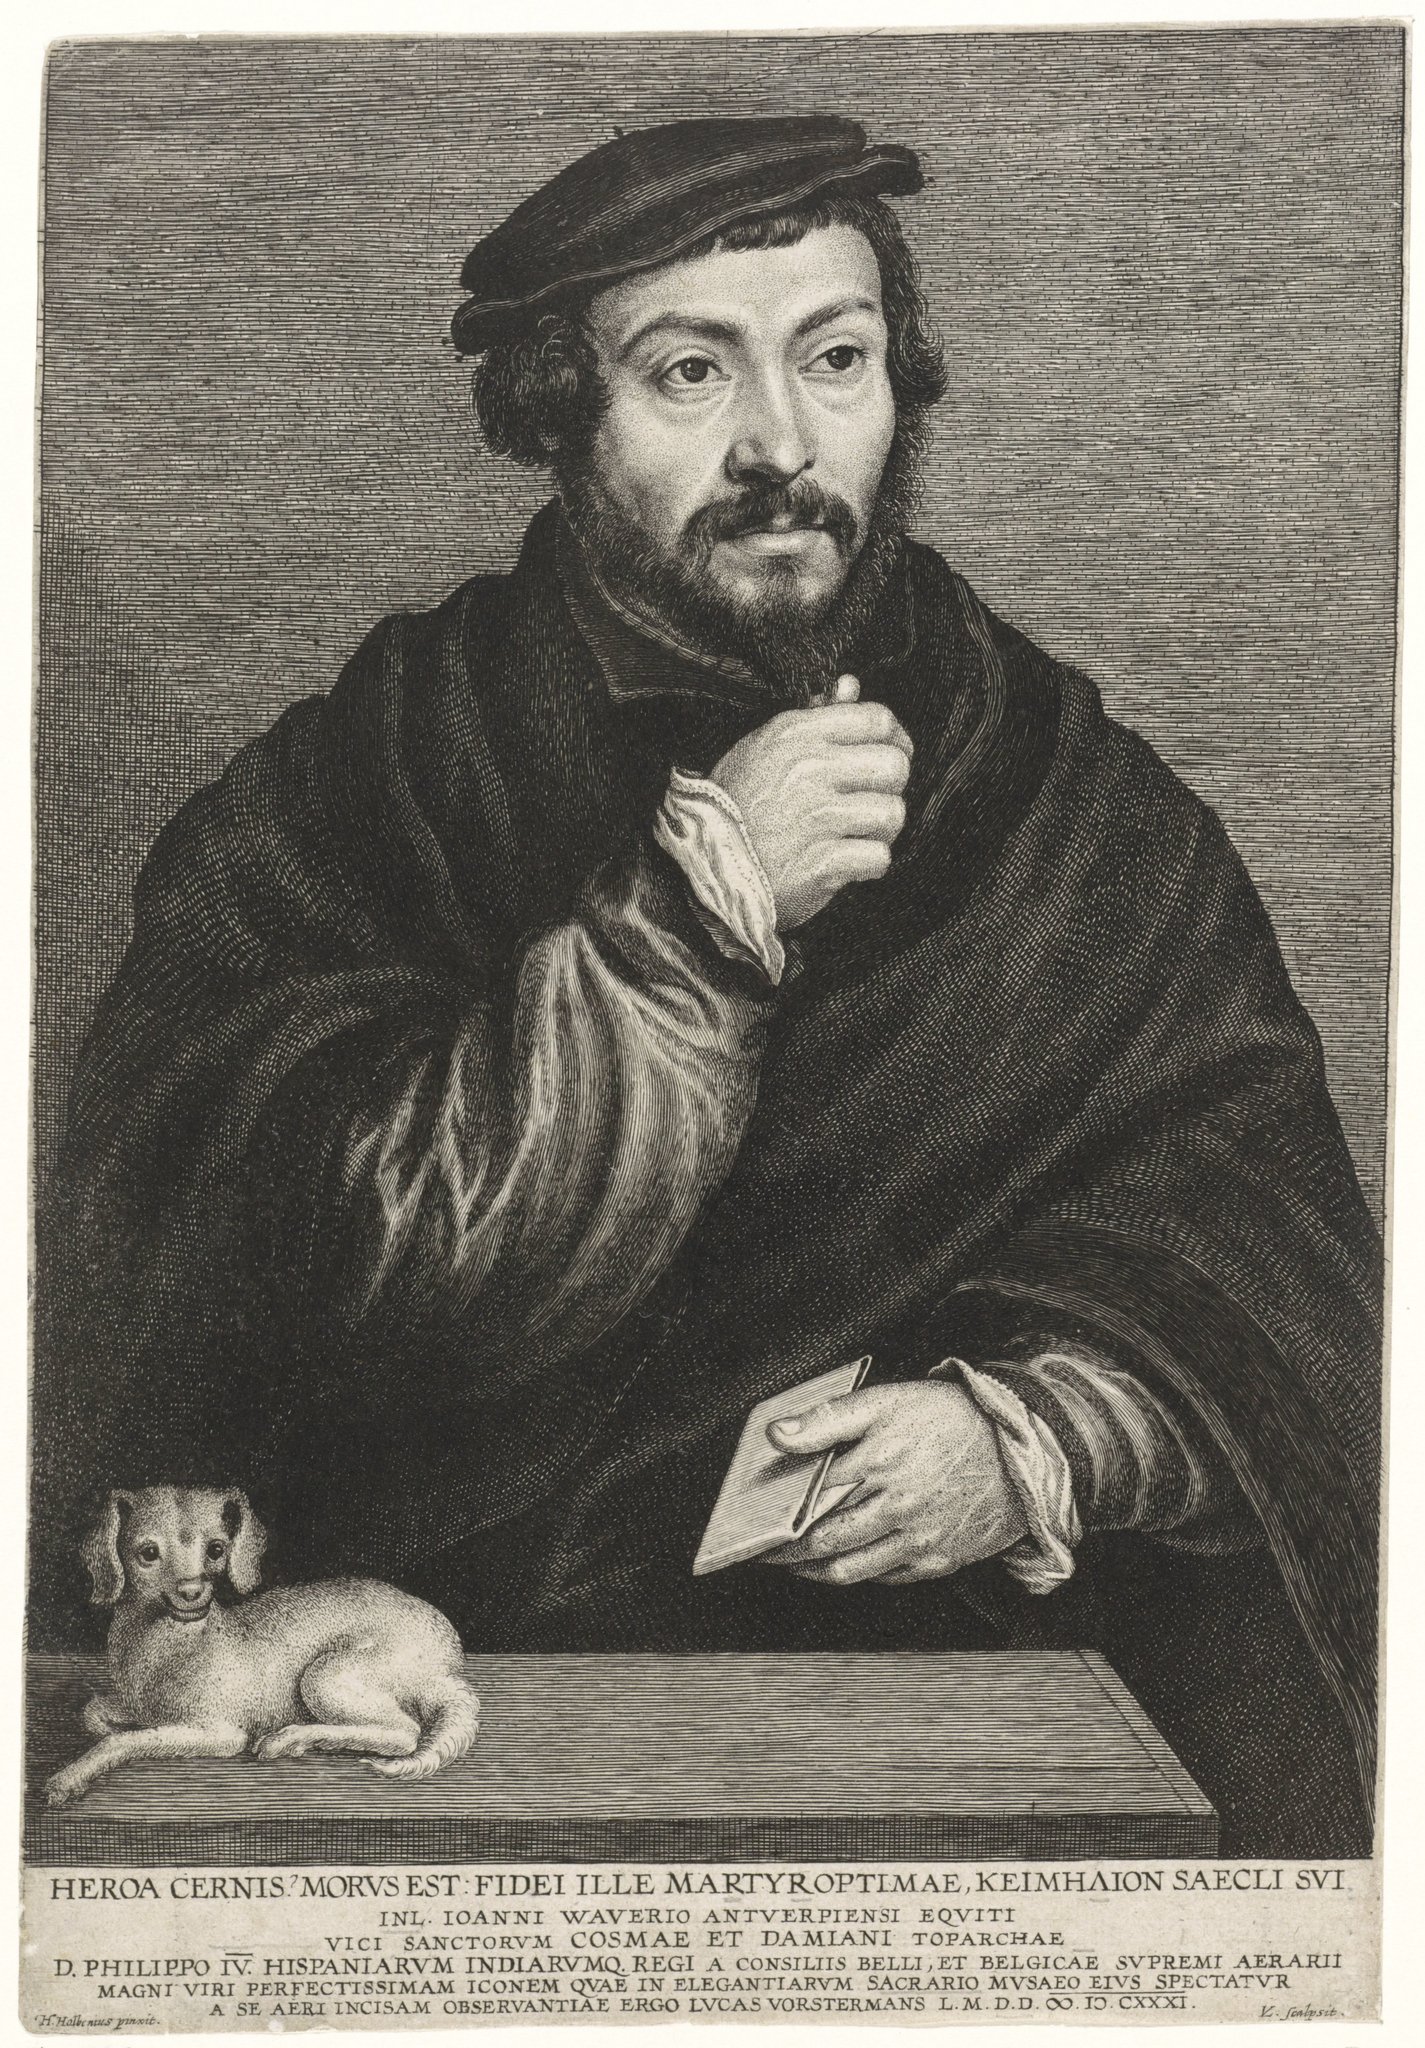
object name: print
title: Portret van sir Thomas More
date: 1631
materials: paper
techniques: engraving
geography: antwerp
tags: letter, envelope, dog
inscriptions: collector's mark: Lugt 2228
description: Portret van de Engelse diplomaat en filosoof sir Thomas More.